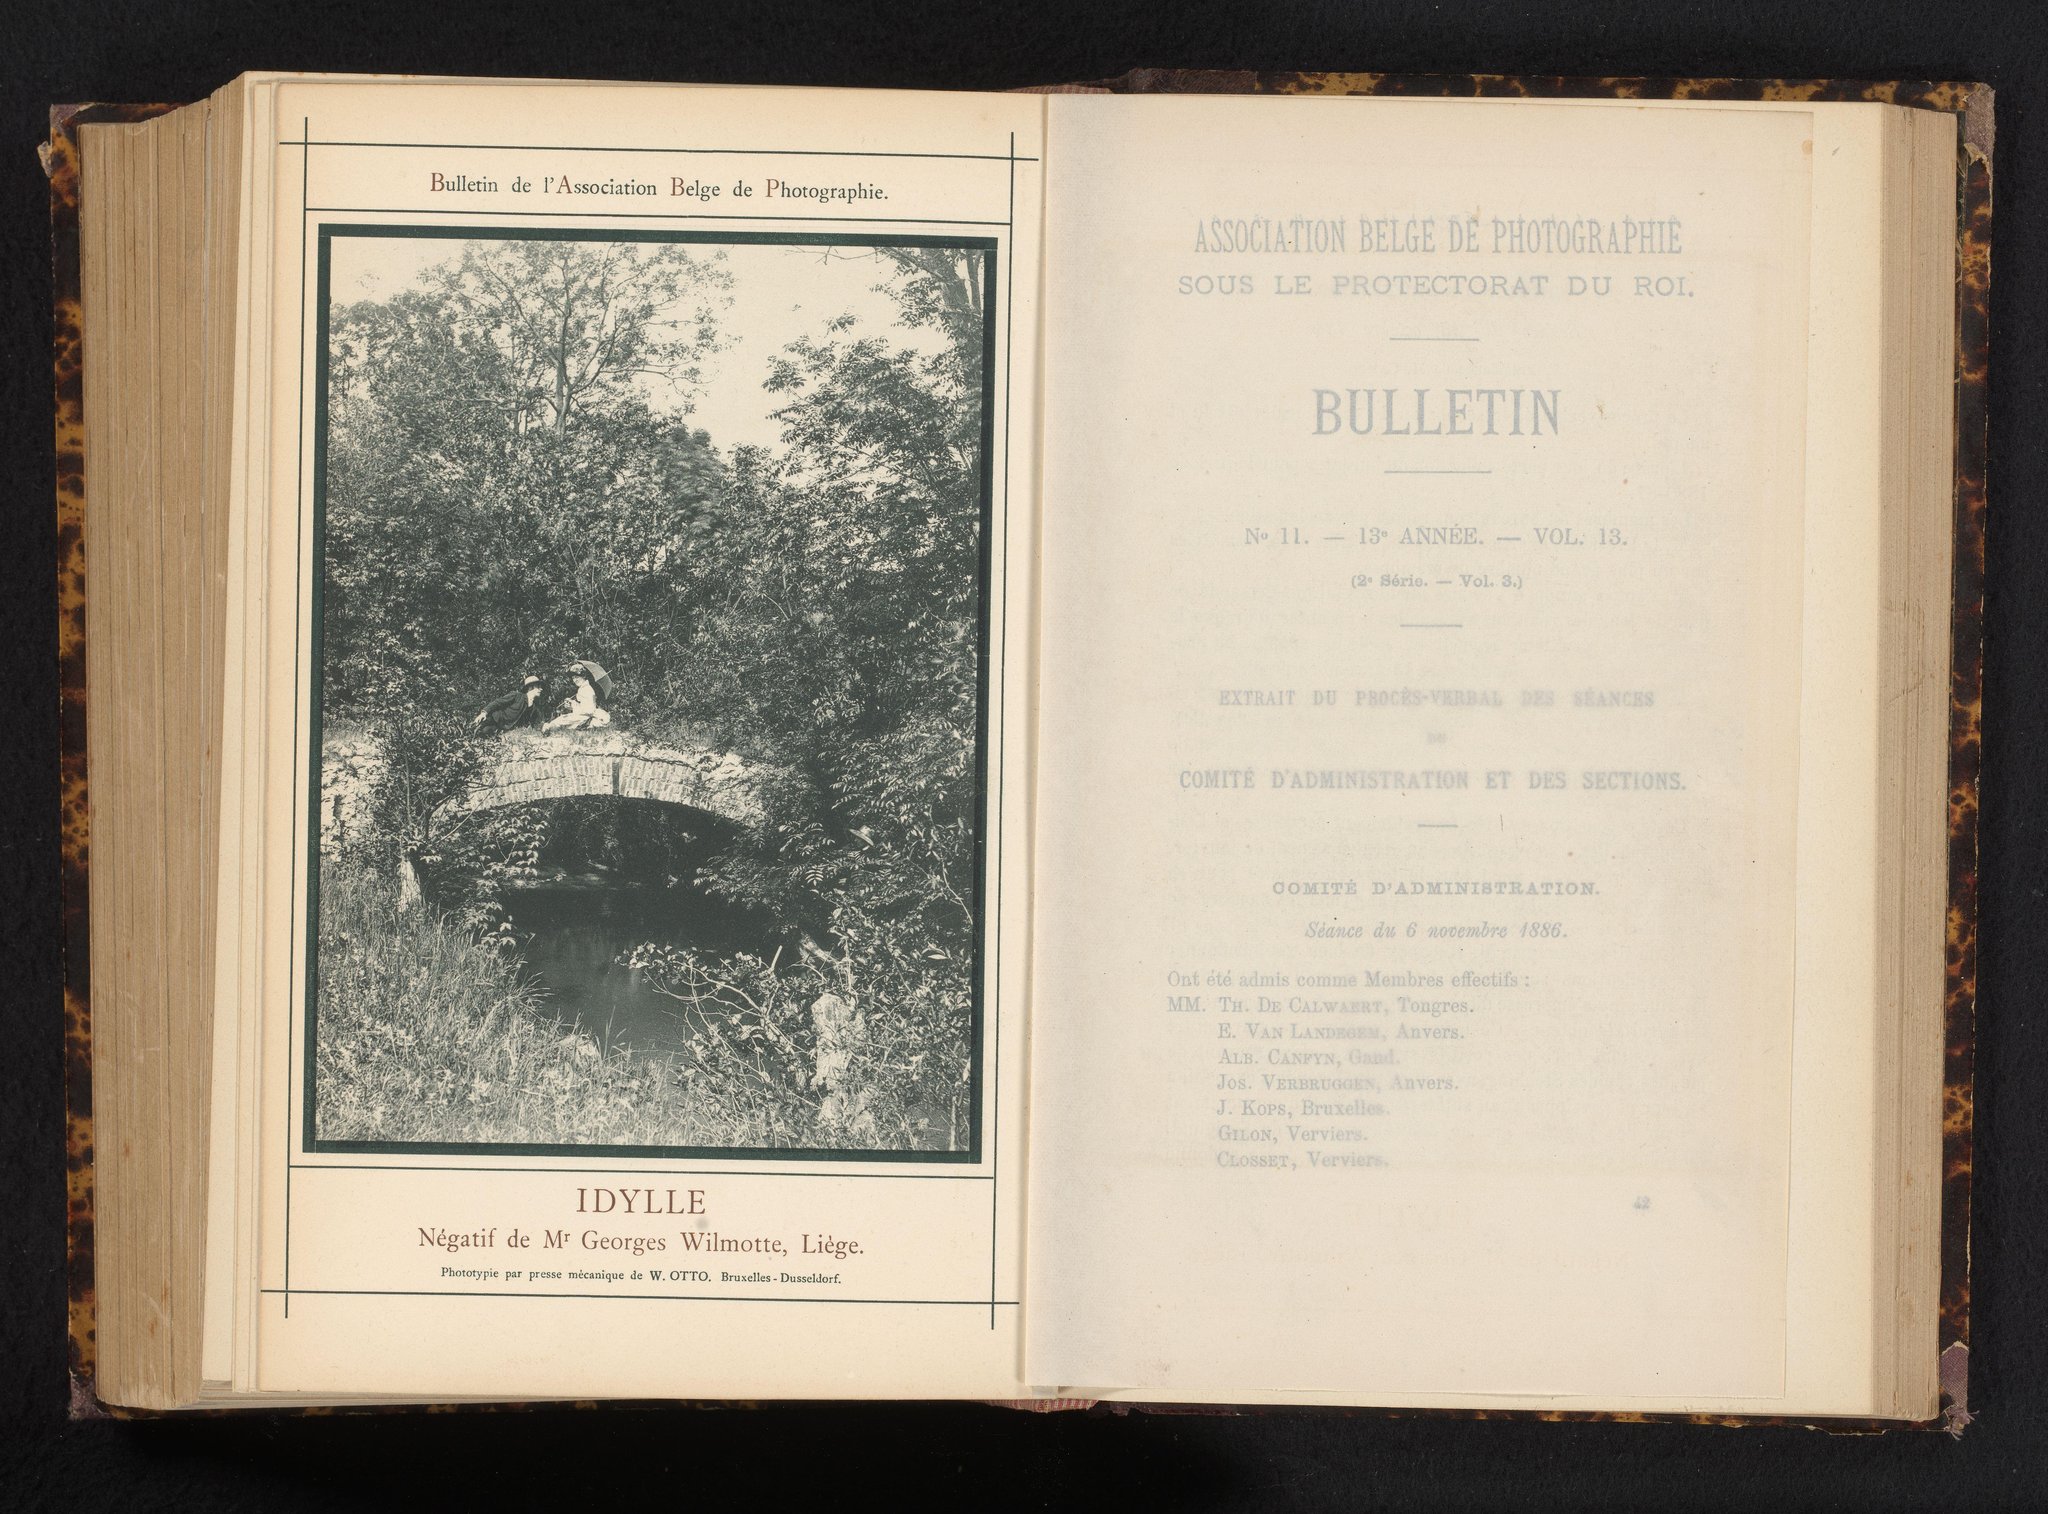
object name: page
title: Man en vrouw op een brug over de Berwinne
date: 1881-1886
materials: paper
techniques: photograph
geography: brussels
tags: brook, lovers' meeting, bridge